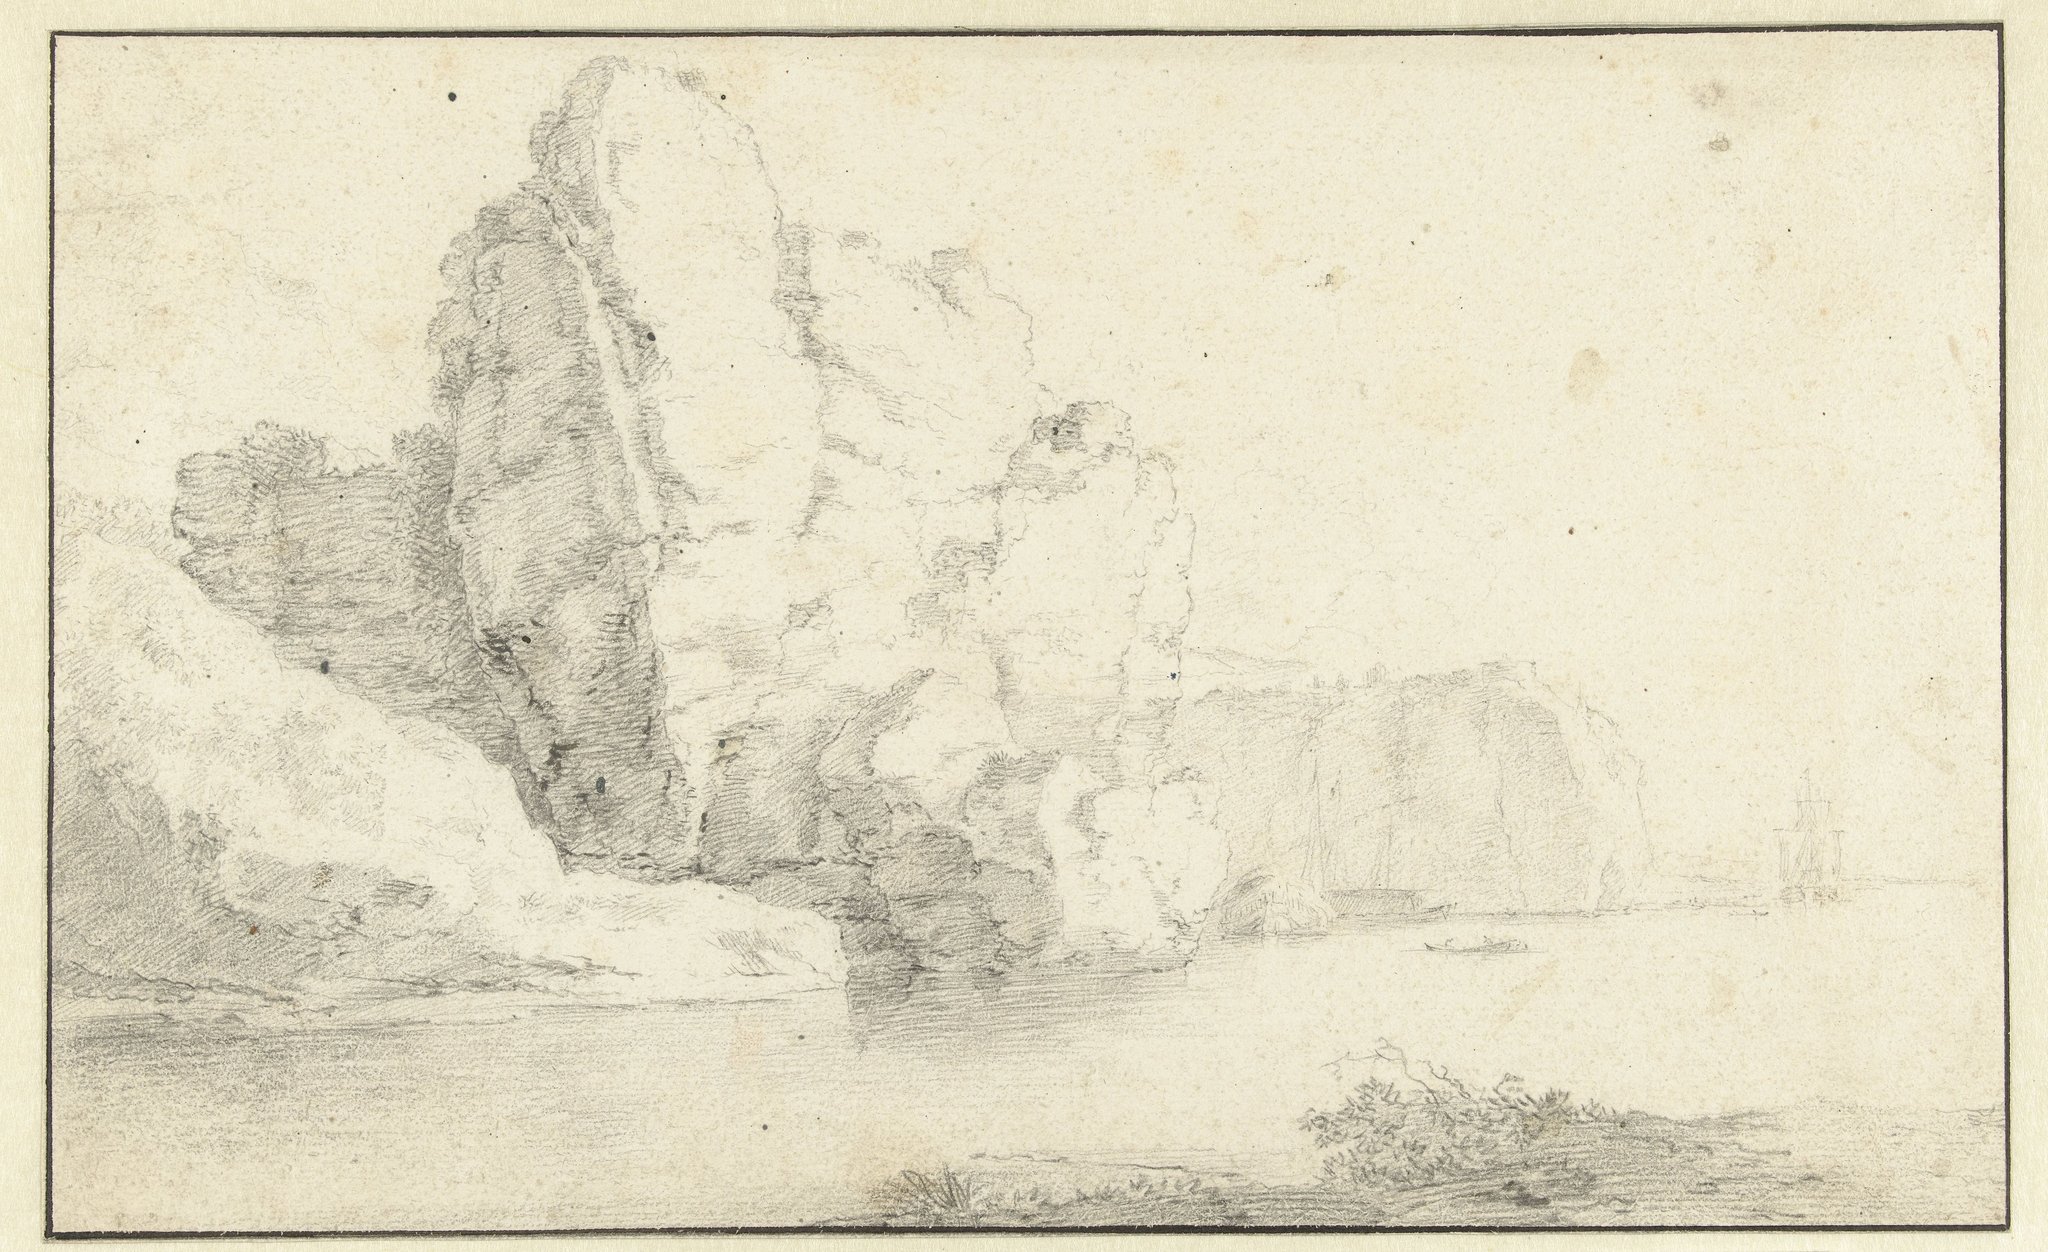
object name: drawing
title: Rotsachtige kust met schepen in de nabijheid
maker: herman naiwincx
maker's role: draughtsman, print maker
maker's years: 1623-1670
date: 1634-1654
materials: chalk, paper, pencil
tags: coast